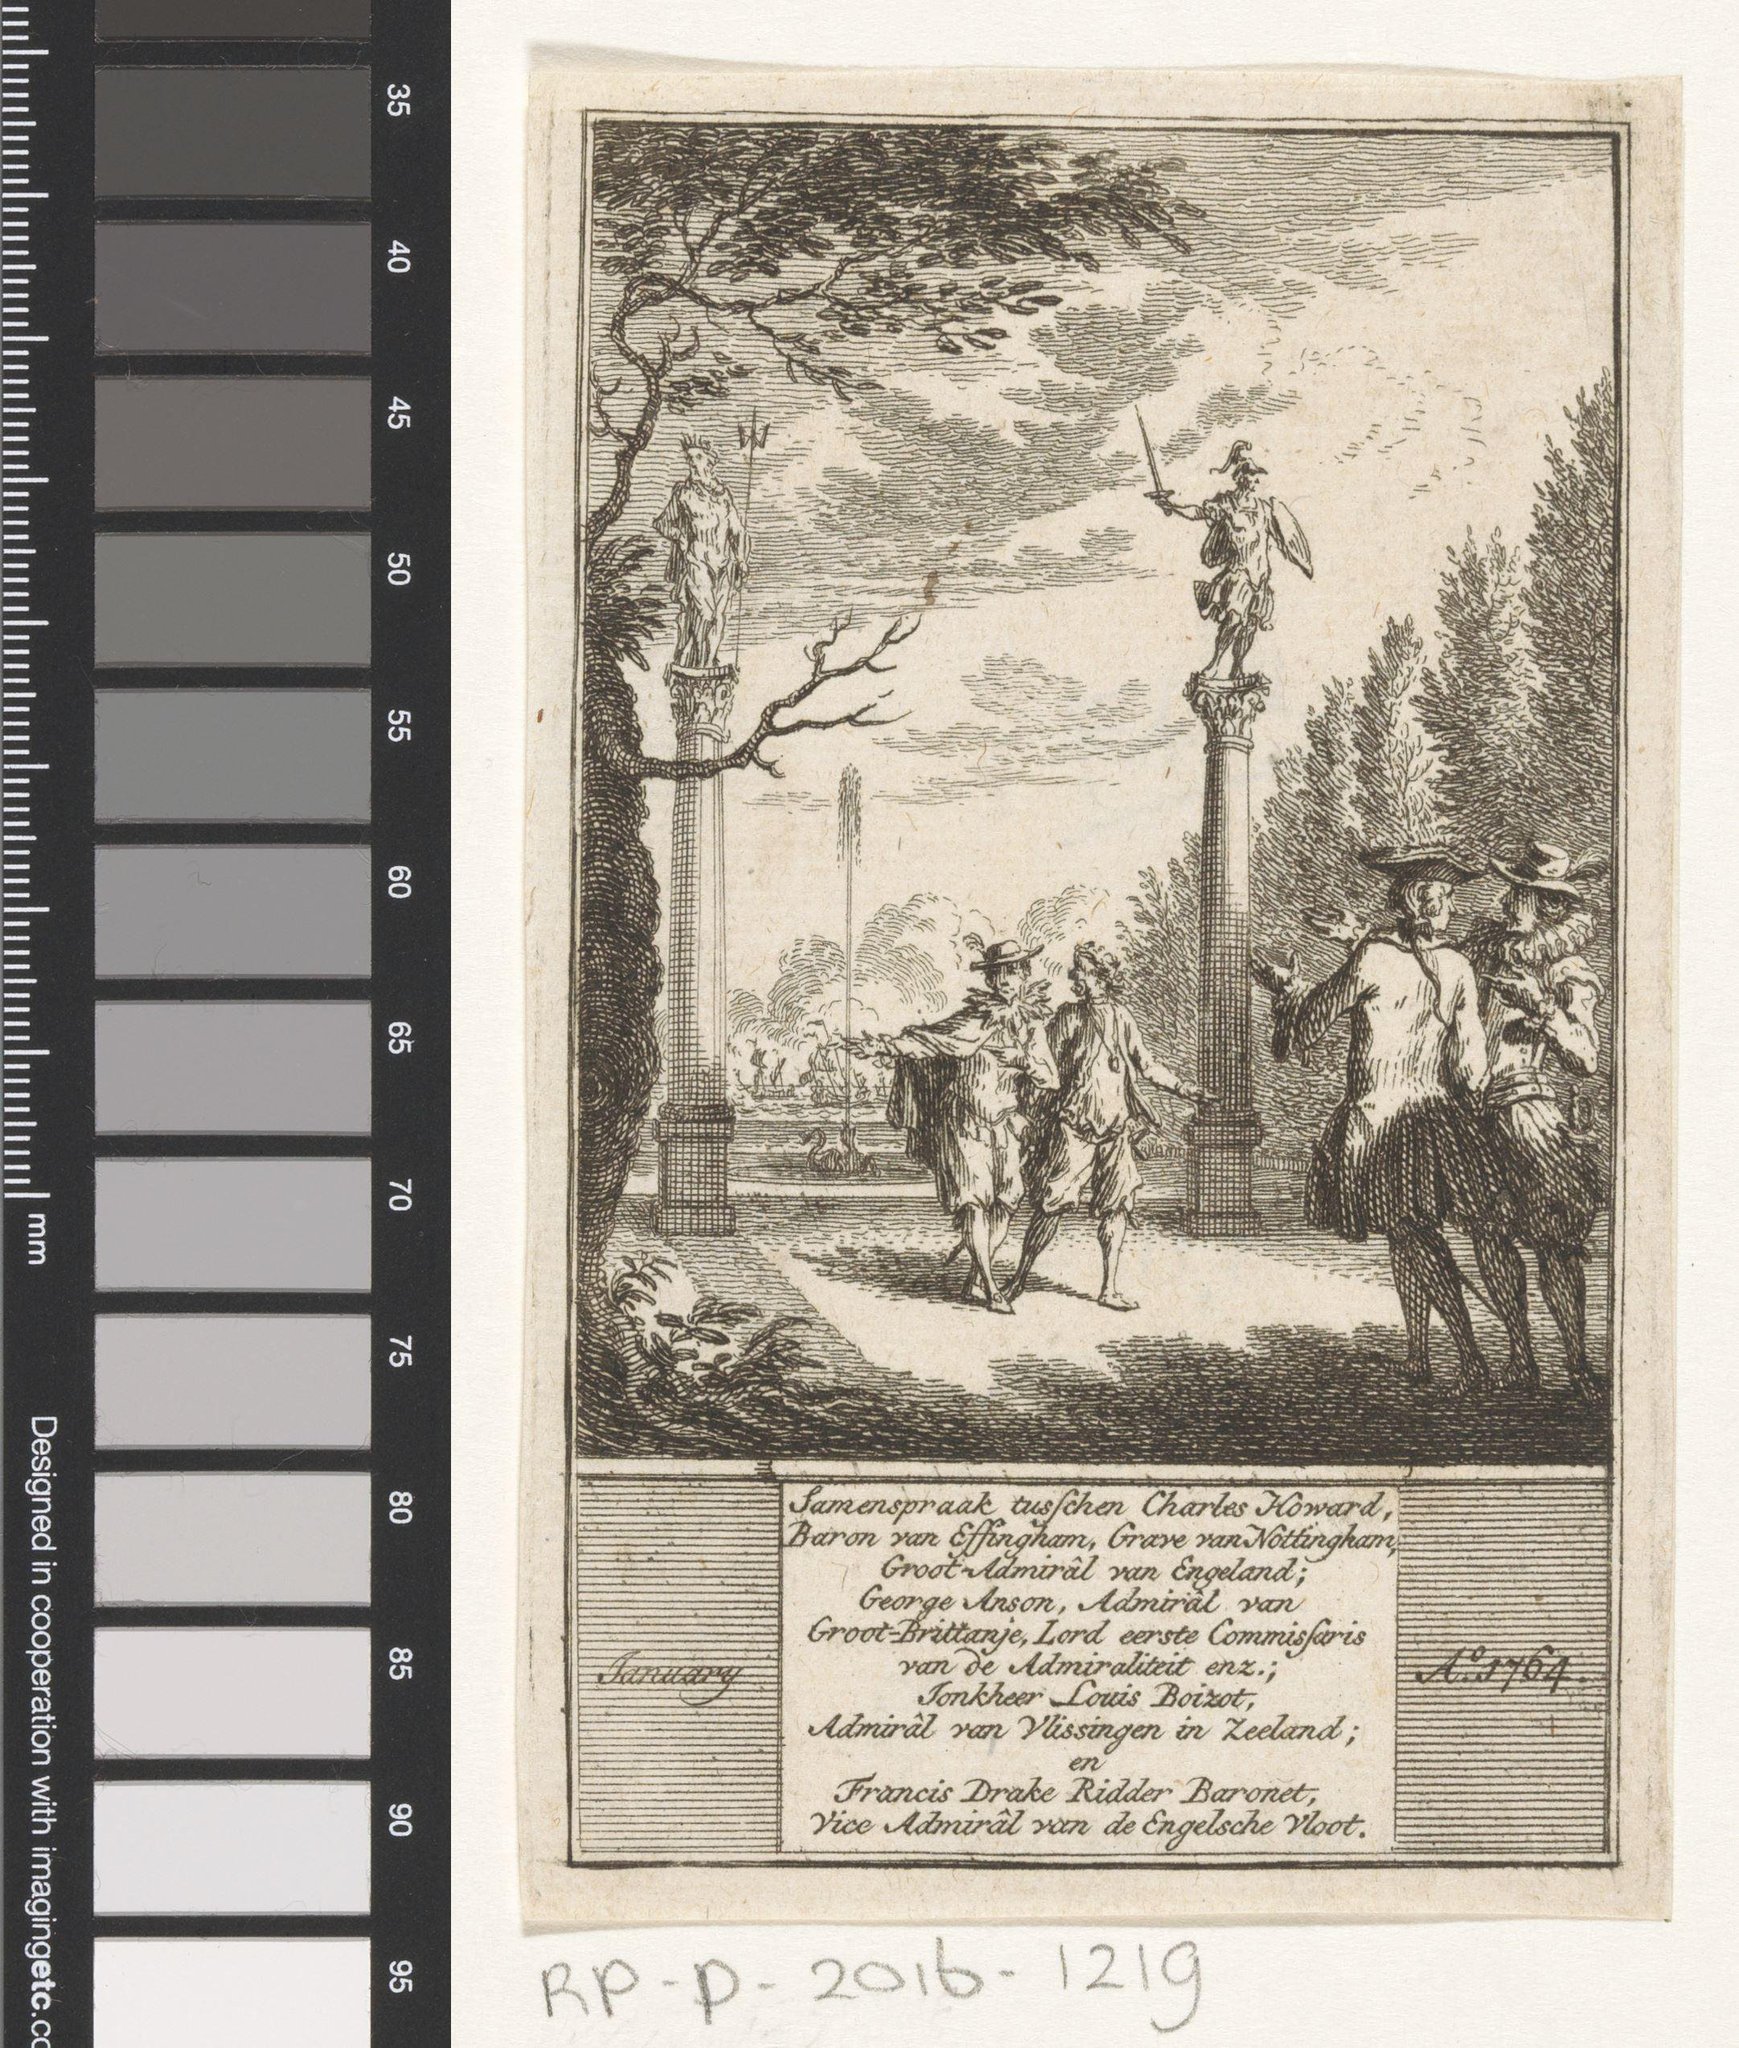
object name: print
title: Samenspraak tusschen Charles Howard, Baron van Effingham, Grave van Nottingham, Groot Admirâl van Engeland; George Anson, Admirâl van Groot-Brittanje, Lord eerste Commissaris van de Admiraliteit enz.; Jonkheer Louis Boizot, Admirâl van Vlissiningen in Zeeland; en Francis Drake Ridder baronet, Vice Admirâl van de Engelsche Vloot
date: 1701-1764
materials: paper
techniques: etching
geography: amsterdam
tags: conversation, dialogue; conversation piece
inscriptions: collector's mark: Lugt 2228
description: In tweetallen lopen Charles Howard, George Anson, Louis de Boisot en Francis Drake in een tuin. Op de achtergrond twee zuilen met beelden van Neptunus en (mogelijk) Minerva. Aan de onderzijde vermeld: January / Ao 1764.